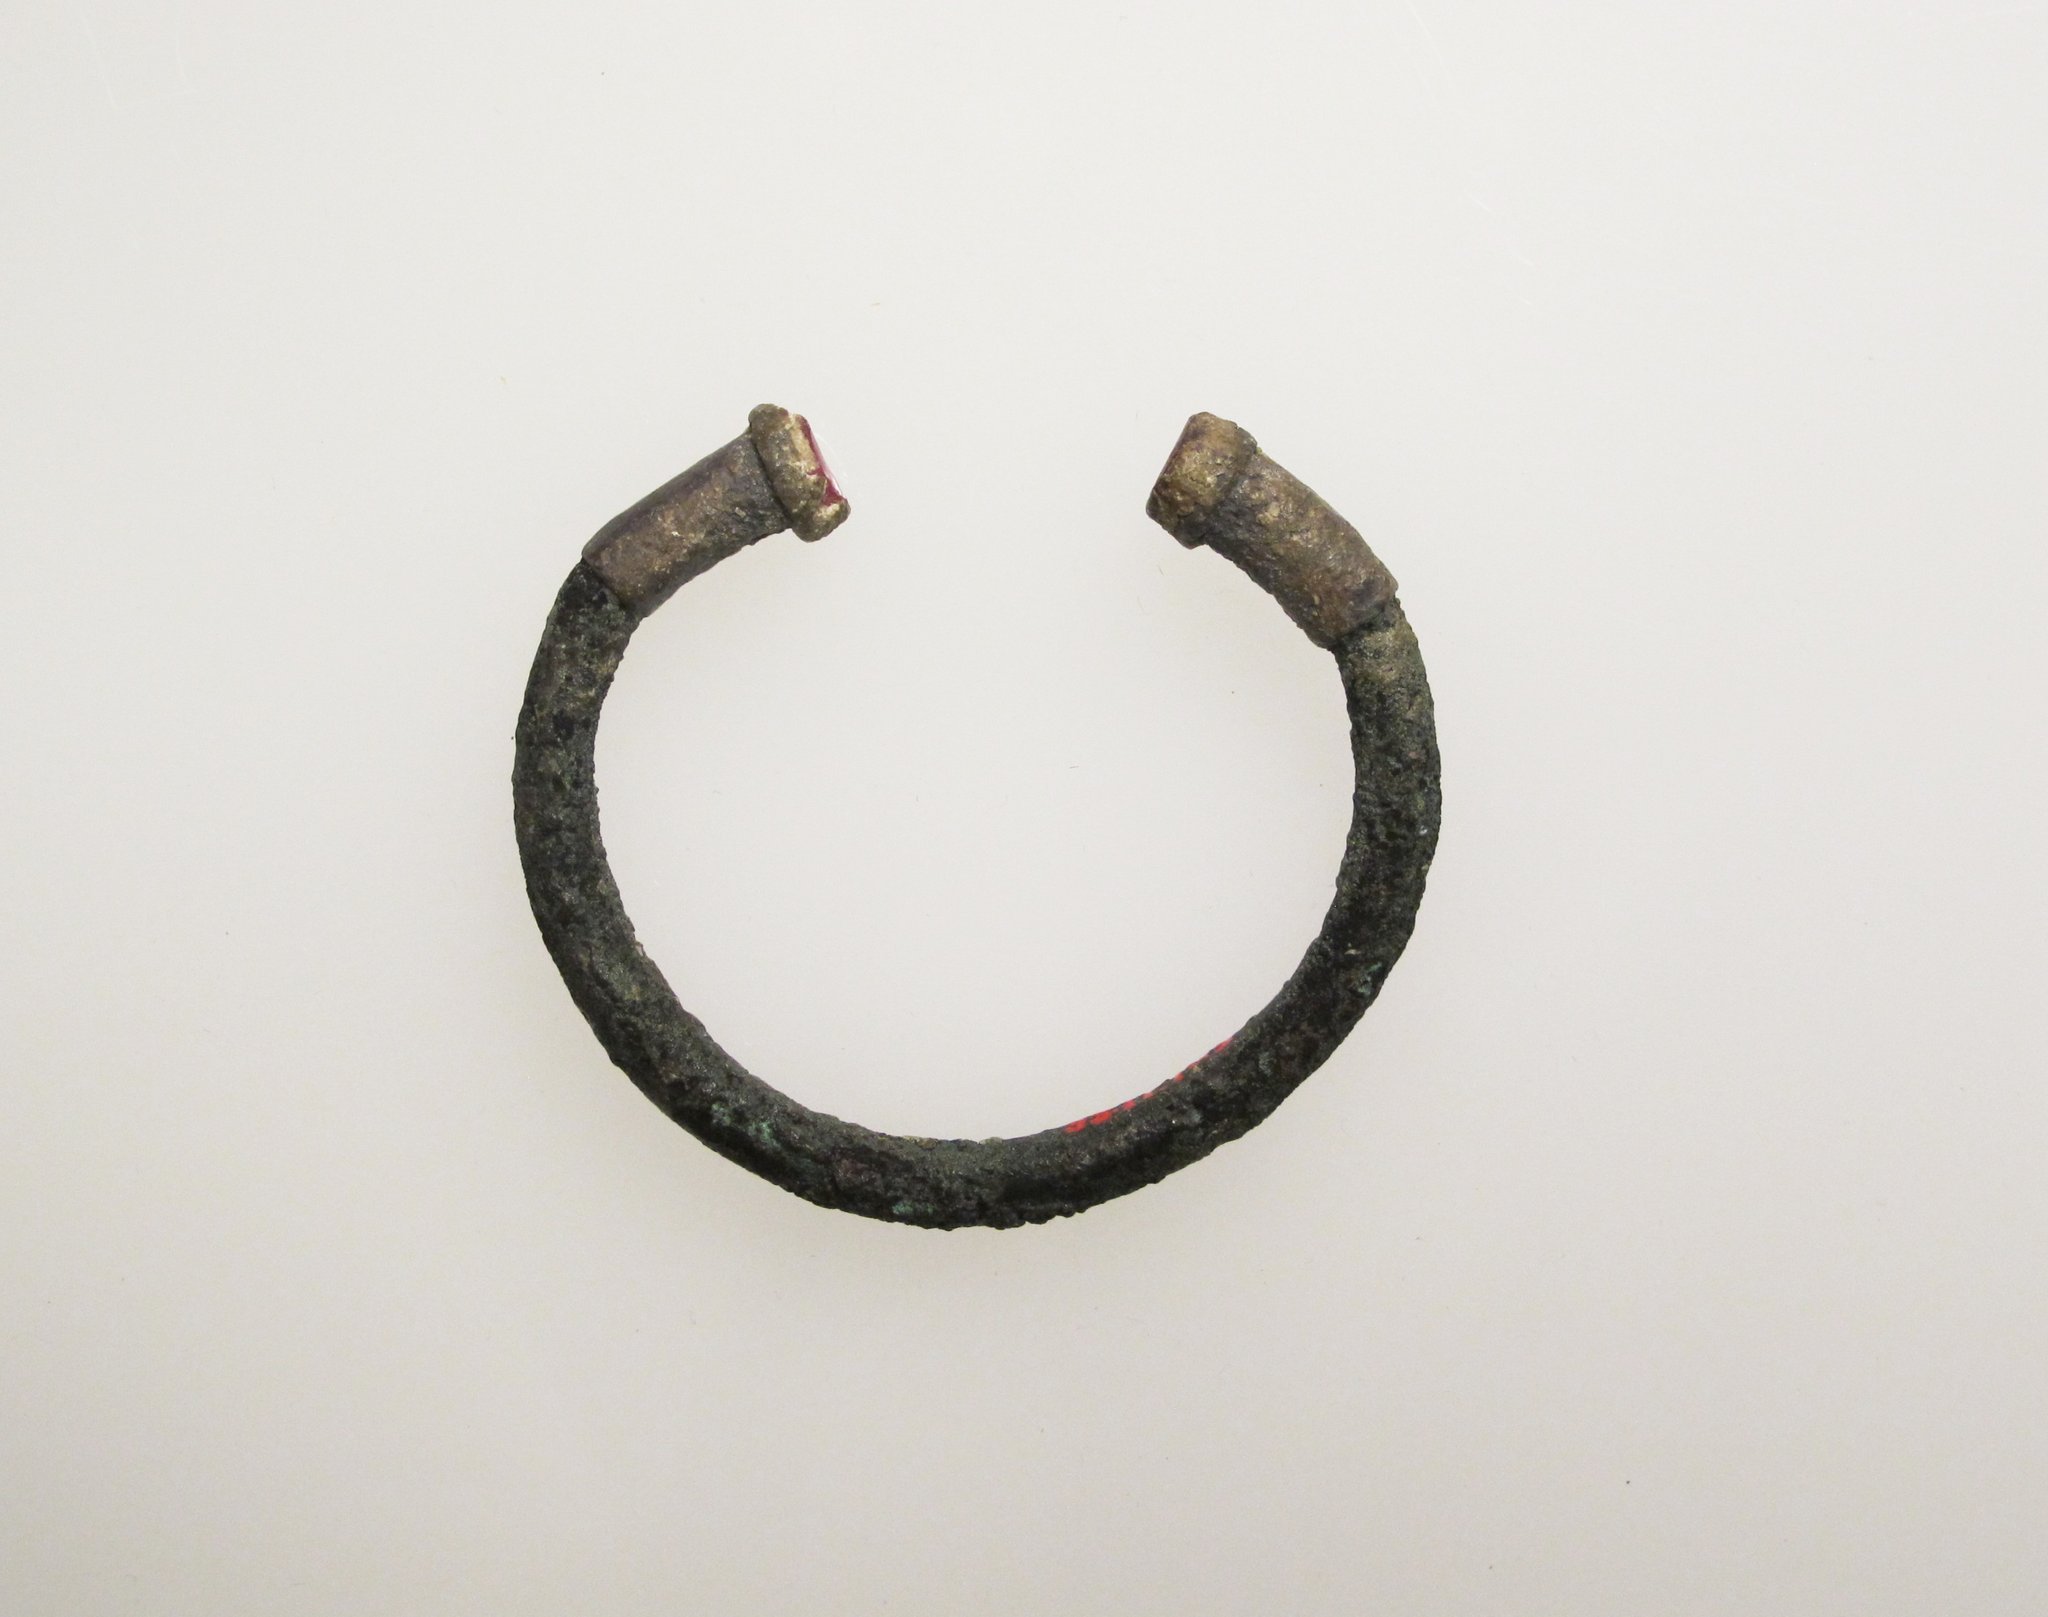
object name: bracelet with red glass paste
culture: roman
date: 201-300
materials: glass, paste, silver